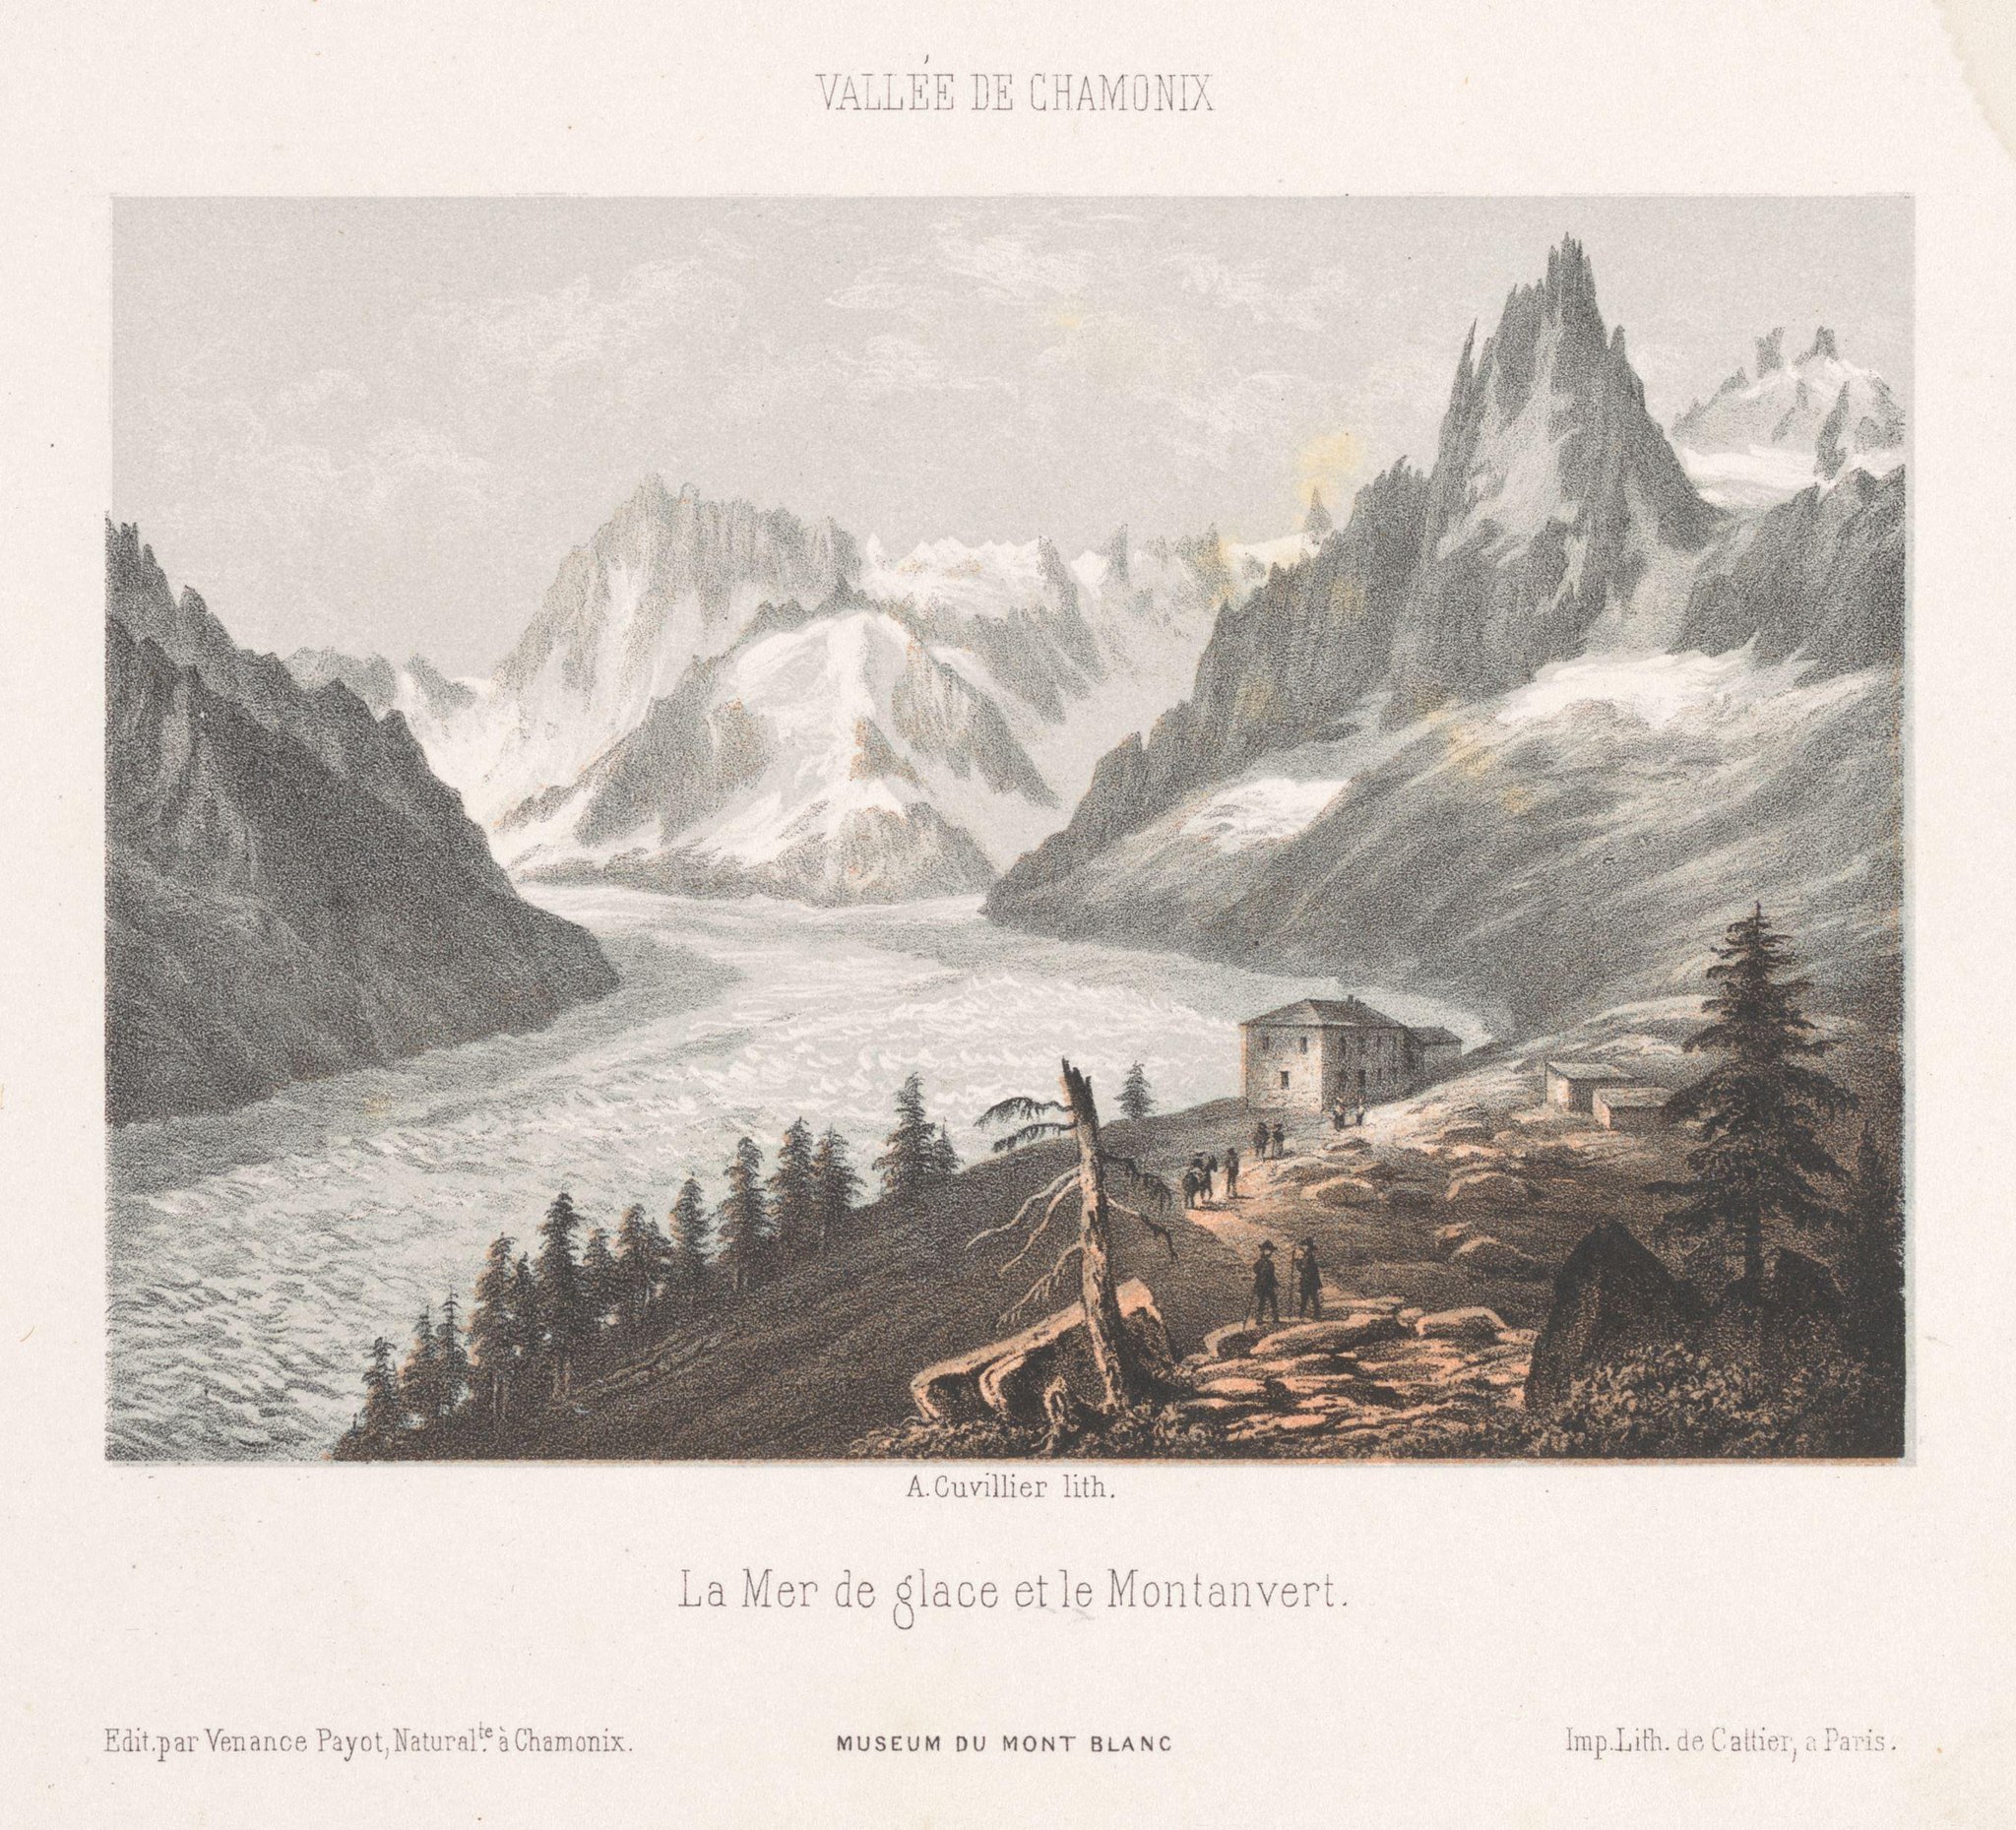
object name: print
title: Museum du Mont-Blanc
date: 1858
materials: paper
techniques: lithograph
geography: paris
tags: glacier (+ landscape with figures, staffage)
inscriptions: collector's mark: Lugt 2228a